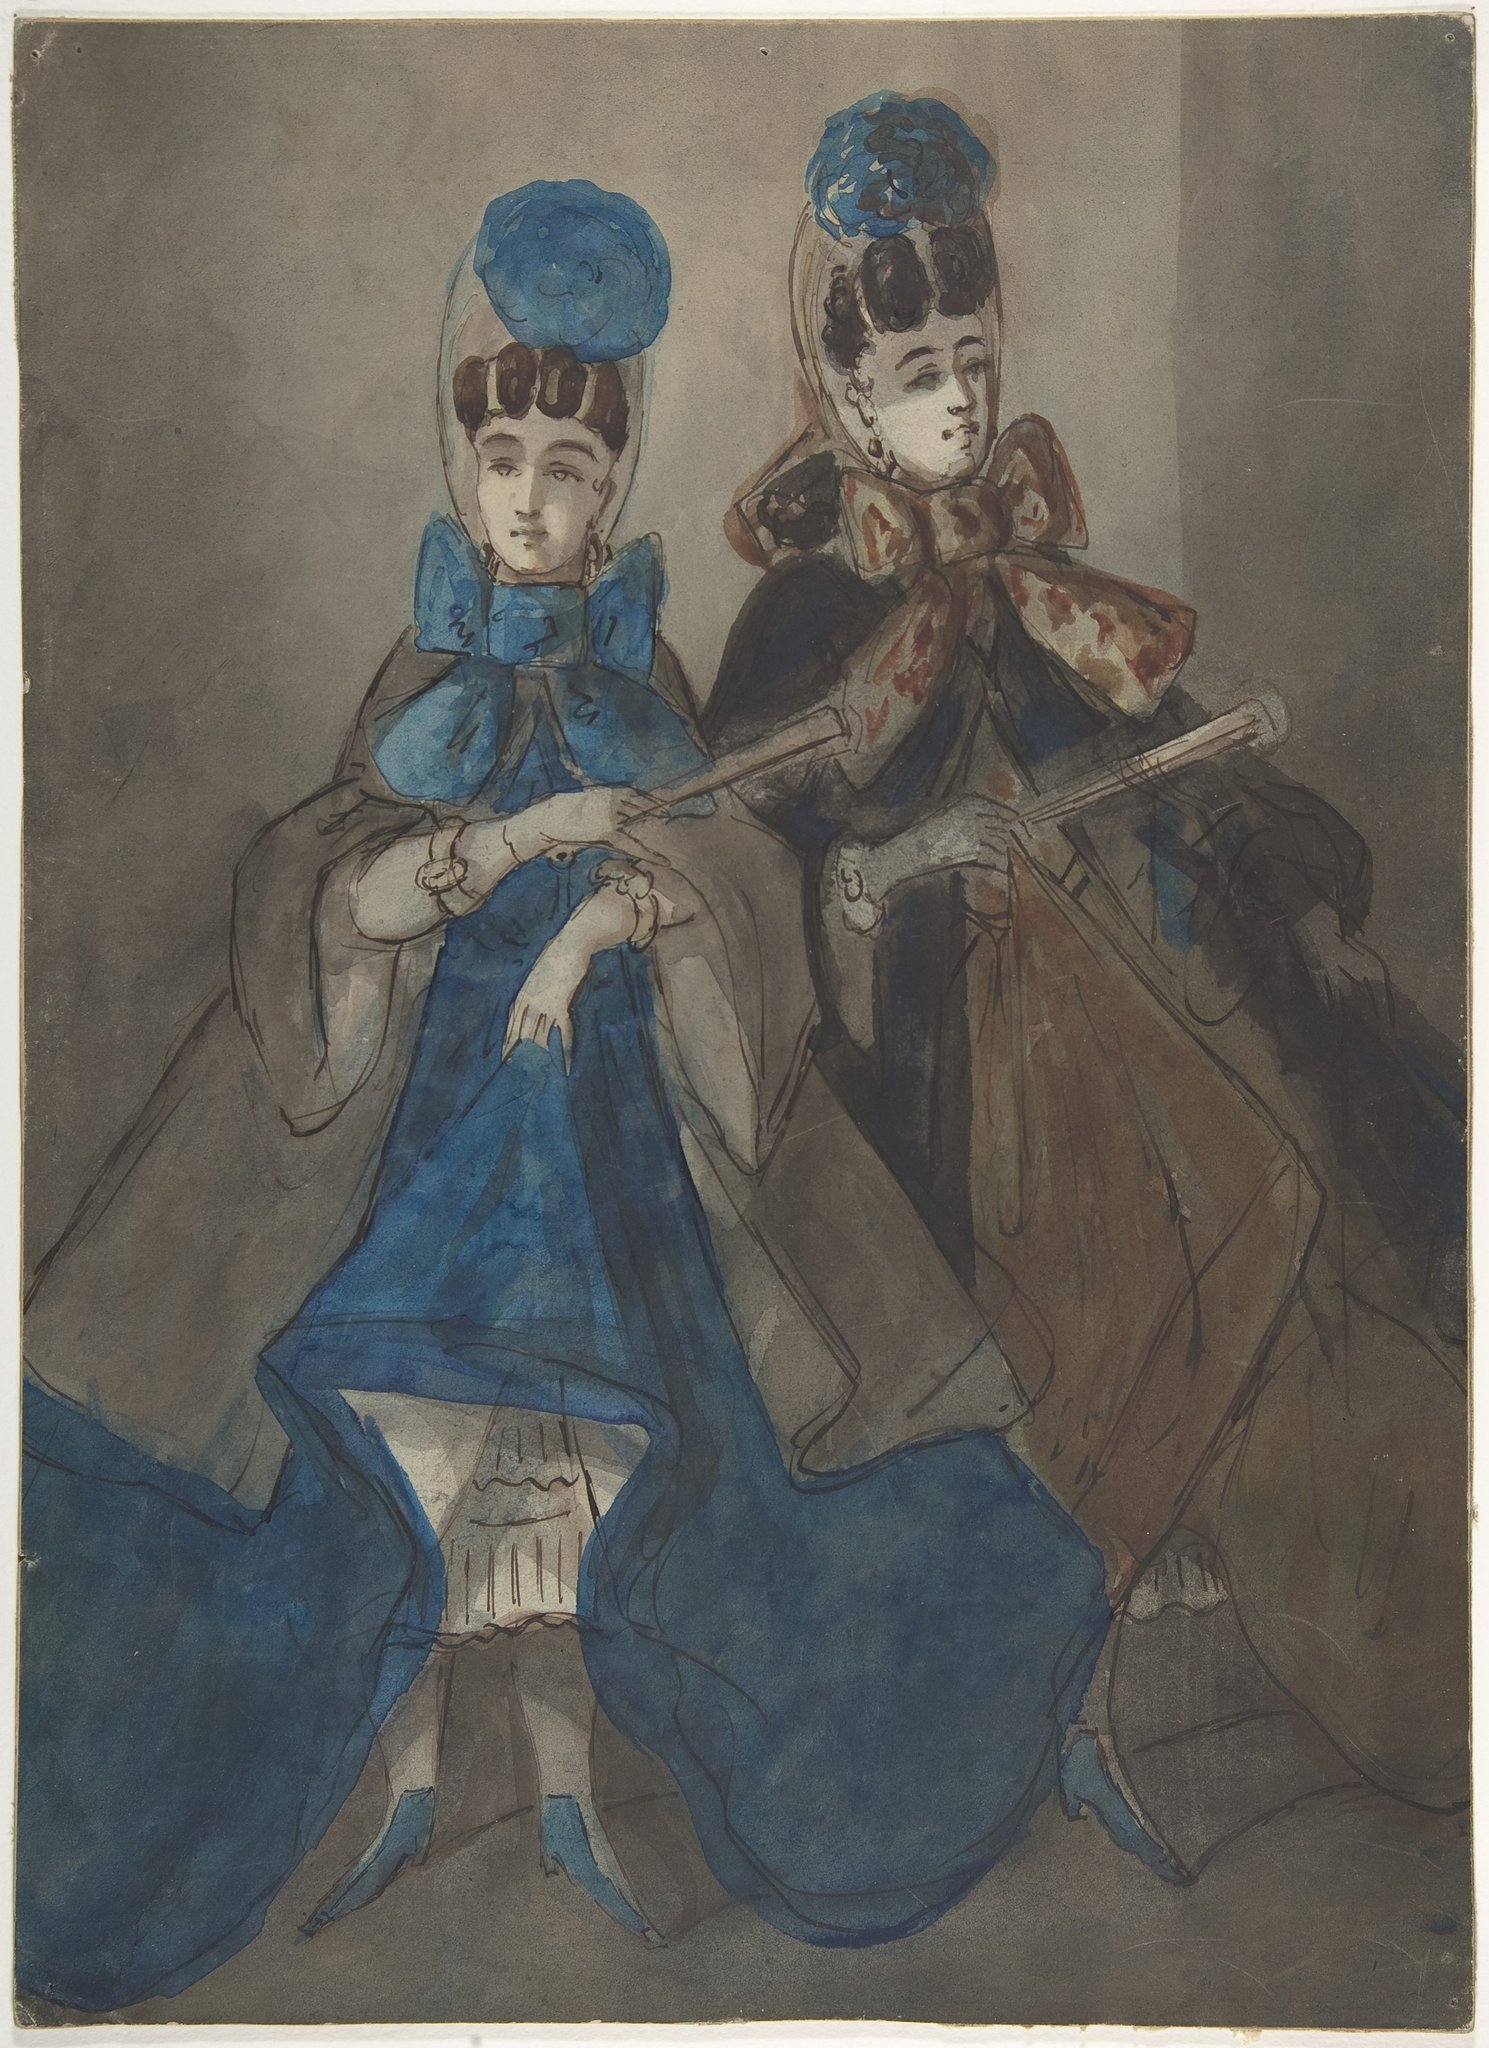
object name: drawing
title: Two Women with Fans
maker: constantin guys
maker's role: artist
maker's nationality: french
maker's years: 1802-1892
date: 1801-1900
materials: ink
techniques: pen, wash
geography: france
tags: fans,women